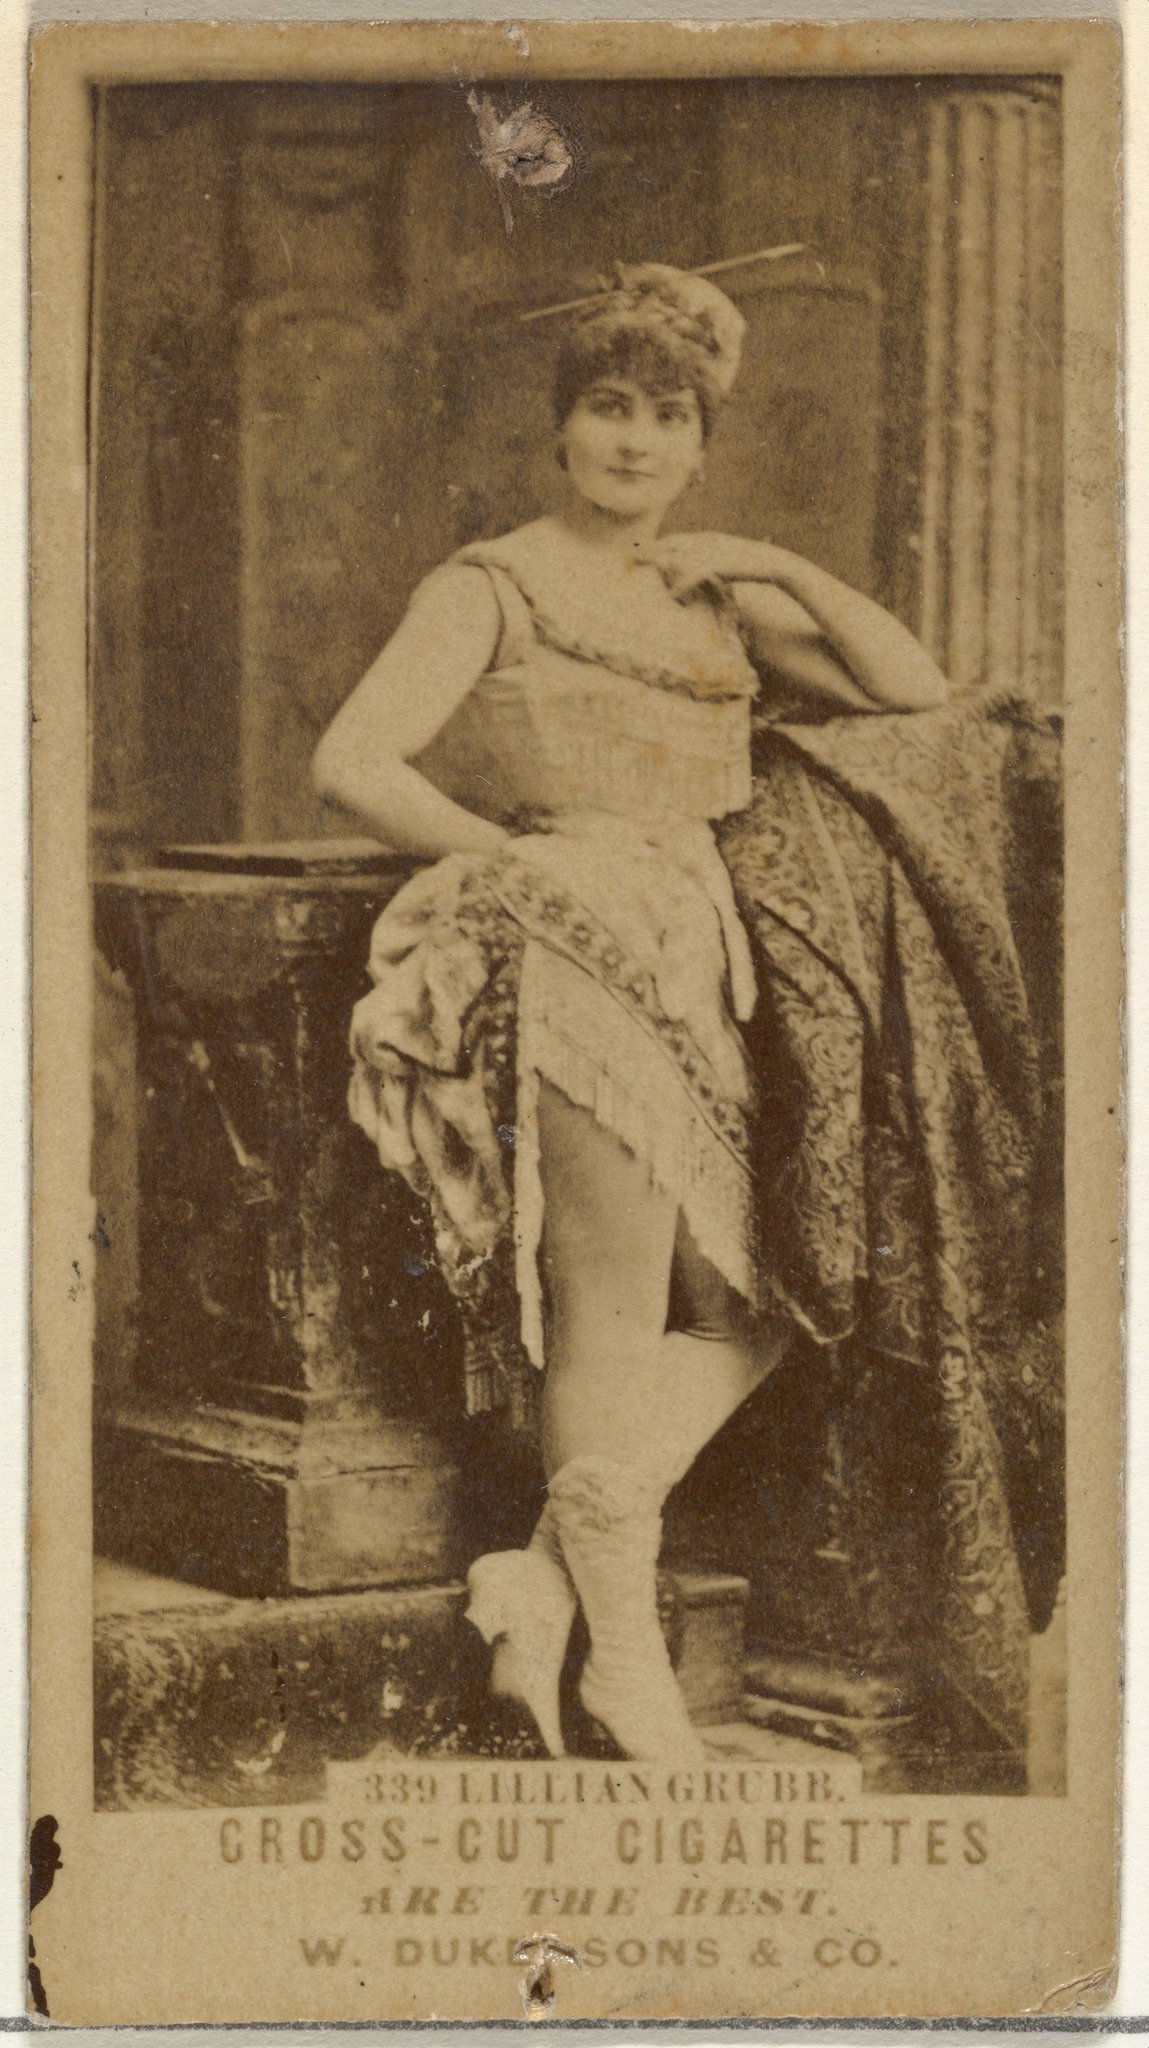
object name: photograph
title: Card Number 339, Lillian Grubb, from the Actors and Actresses series (N145-3) issued by Duke Sons & Co. to promote Cross Cut Cigarettes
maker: w. duke, sons & co.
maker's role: publisher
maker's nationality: american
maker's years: 1870-1920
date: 1880-1889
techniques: albumen silver print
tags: portraits,women,actresses